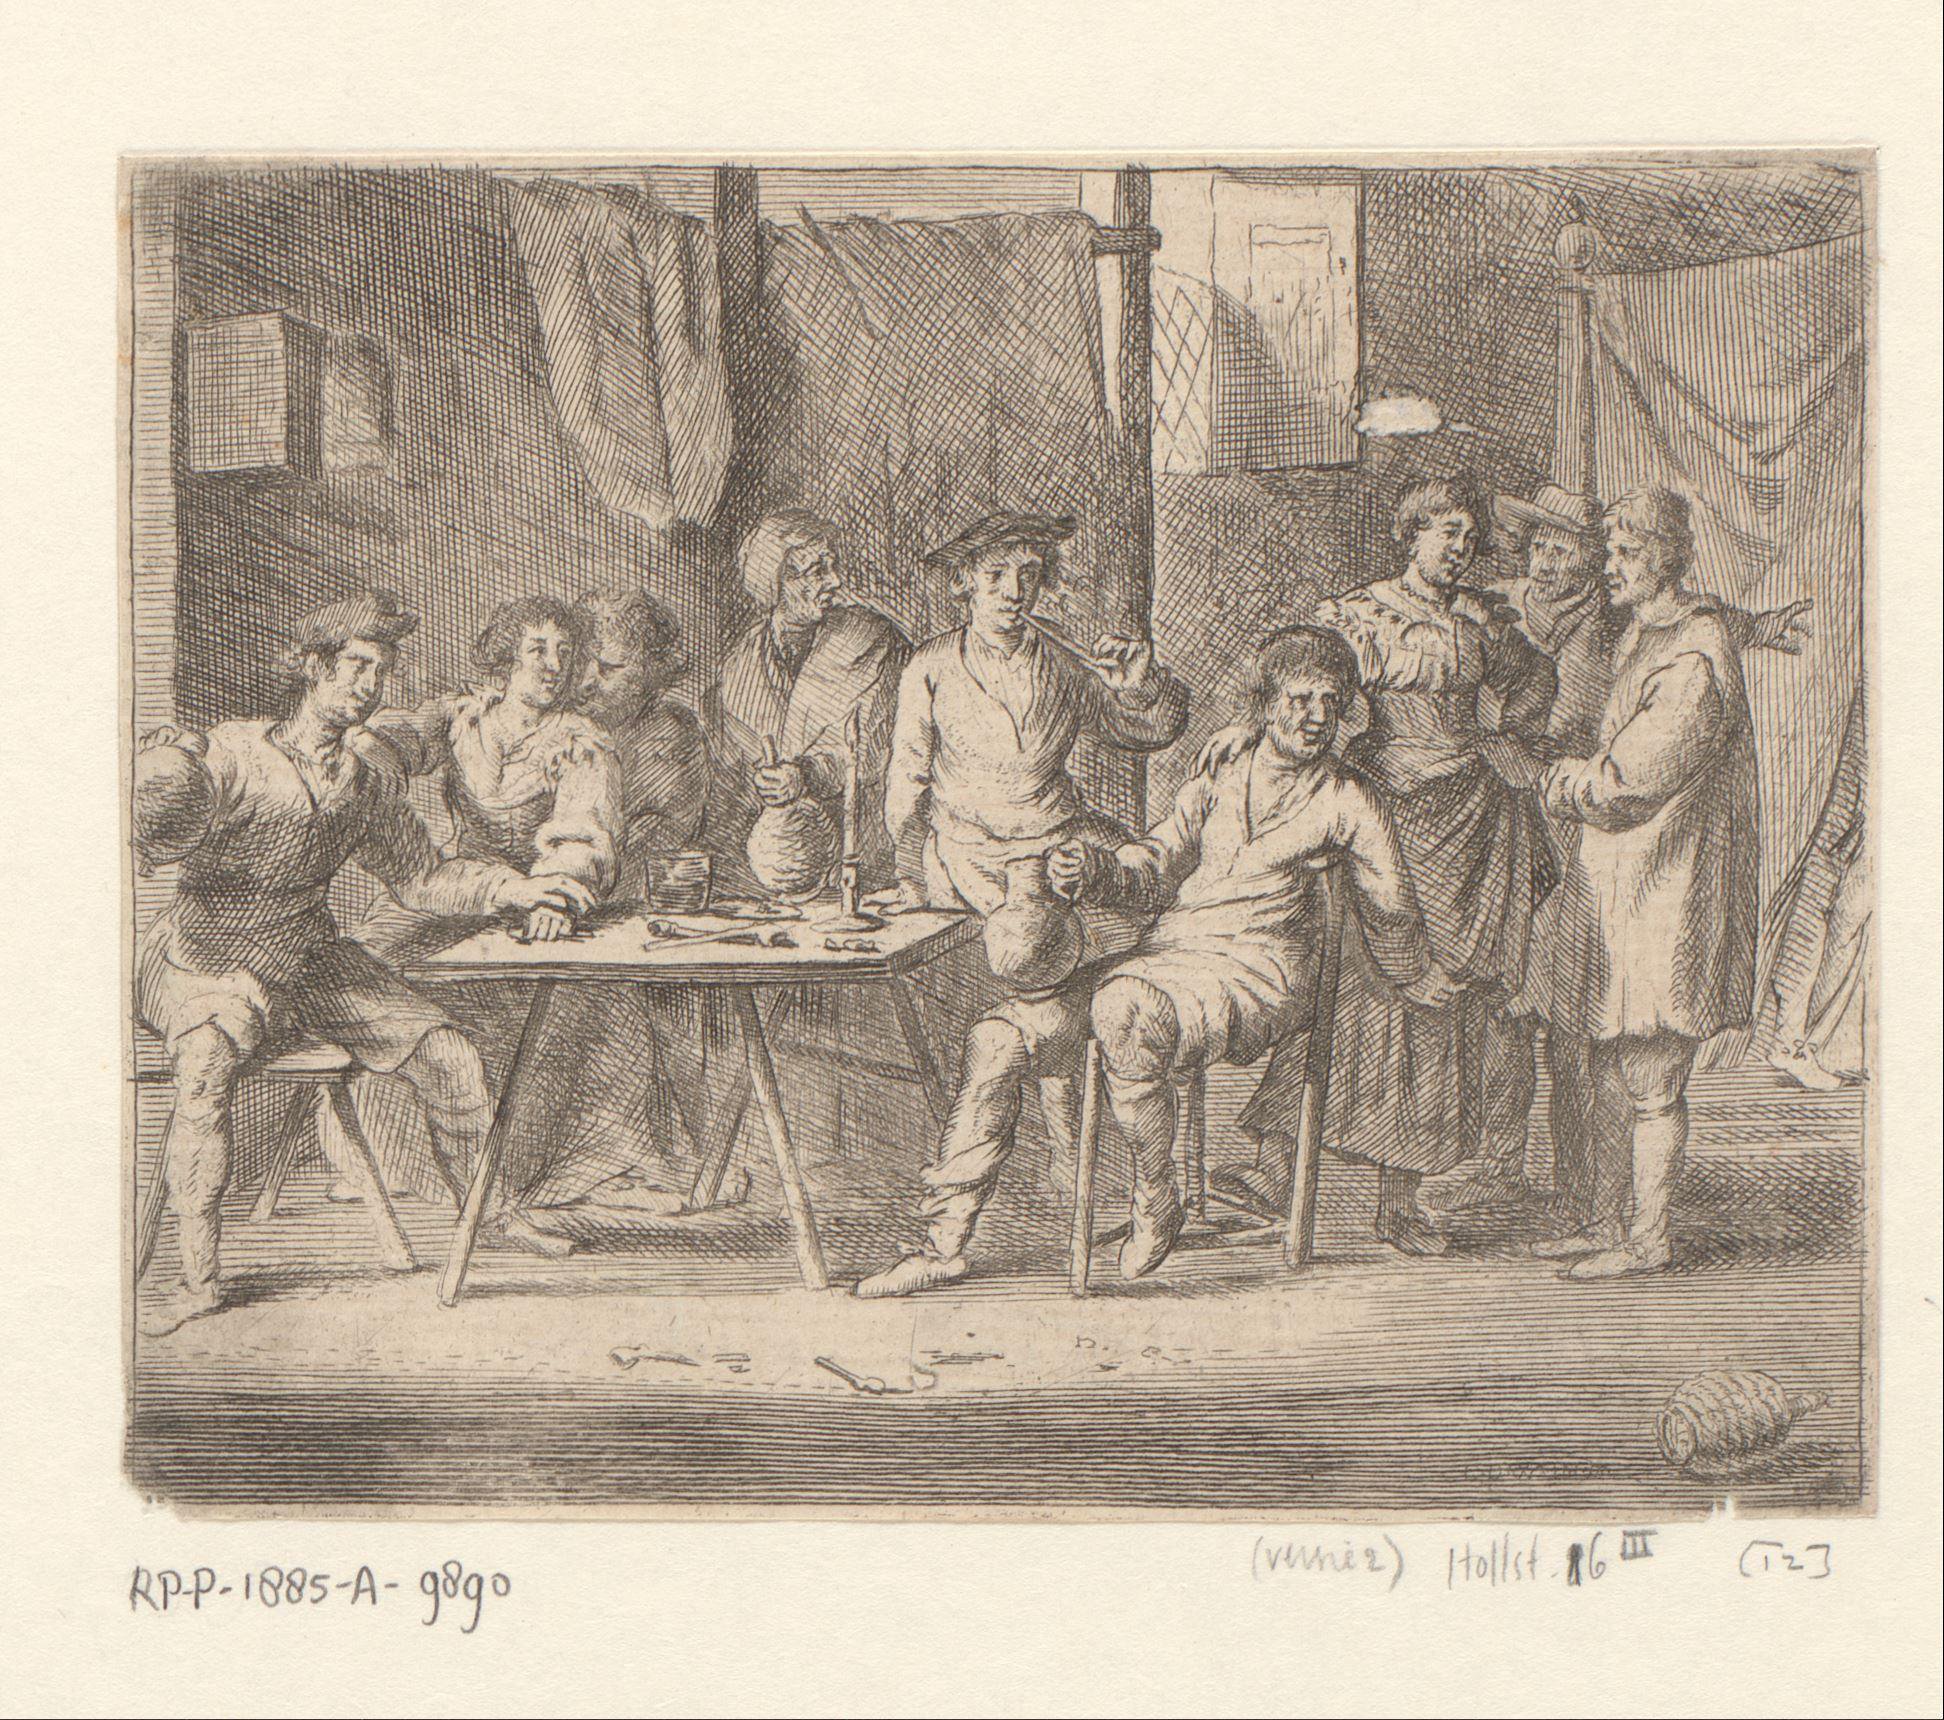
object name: print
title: Gezelschap in een herberg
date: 1630-1698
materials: paper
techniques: engraving, etching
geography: italy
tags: inn, coffee-house, public house, etc., lovers; courting, flirting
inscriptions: collector's mark: Lugt 2228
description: Interieur van een herberg met mannen en vrouwen die roken en drinken. De herbergierster zet een kan drank op tafel. Rechts op de achtergrond staan twee mannen met een vrouw te praten. Eén van hen wijst naar een gordijn waarachter een been te voorschijn komt.